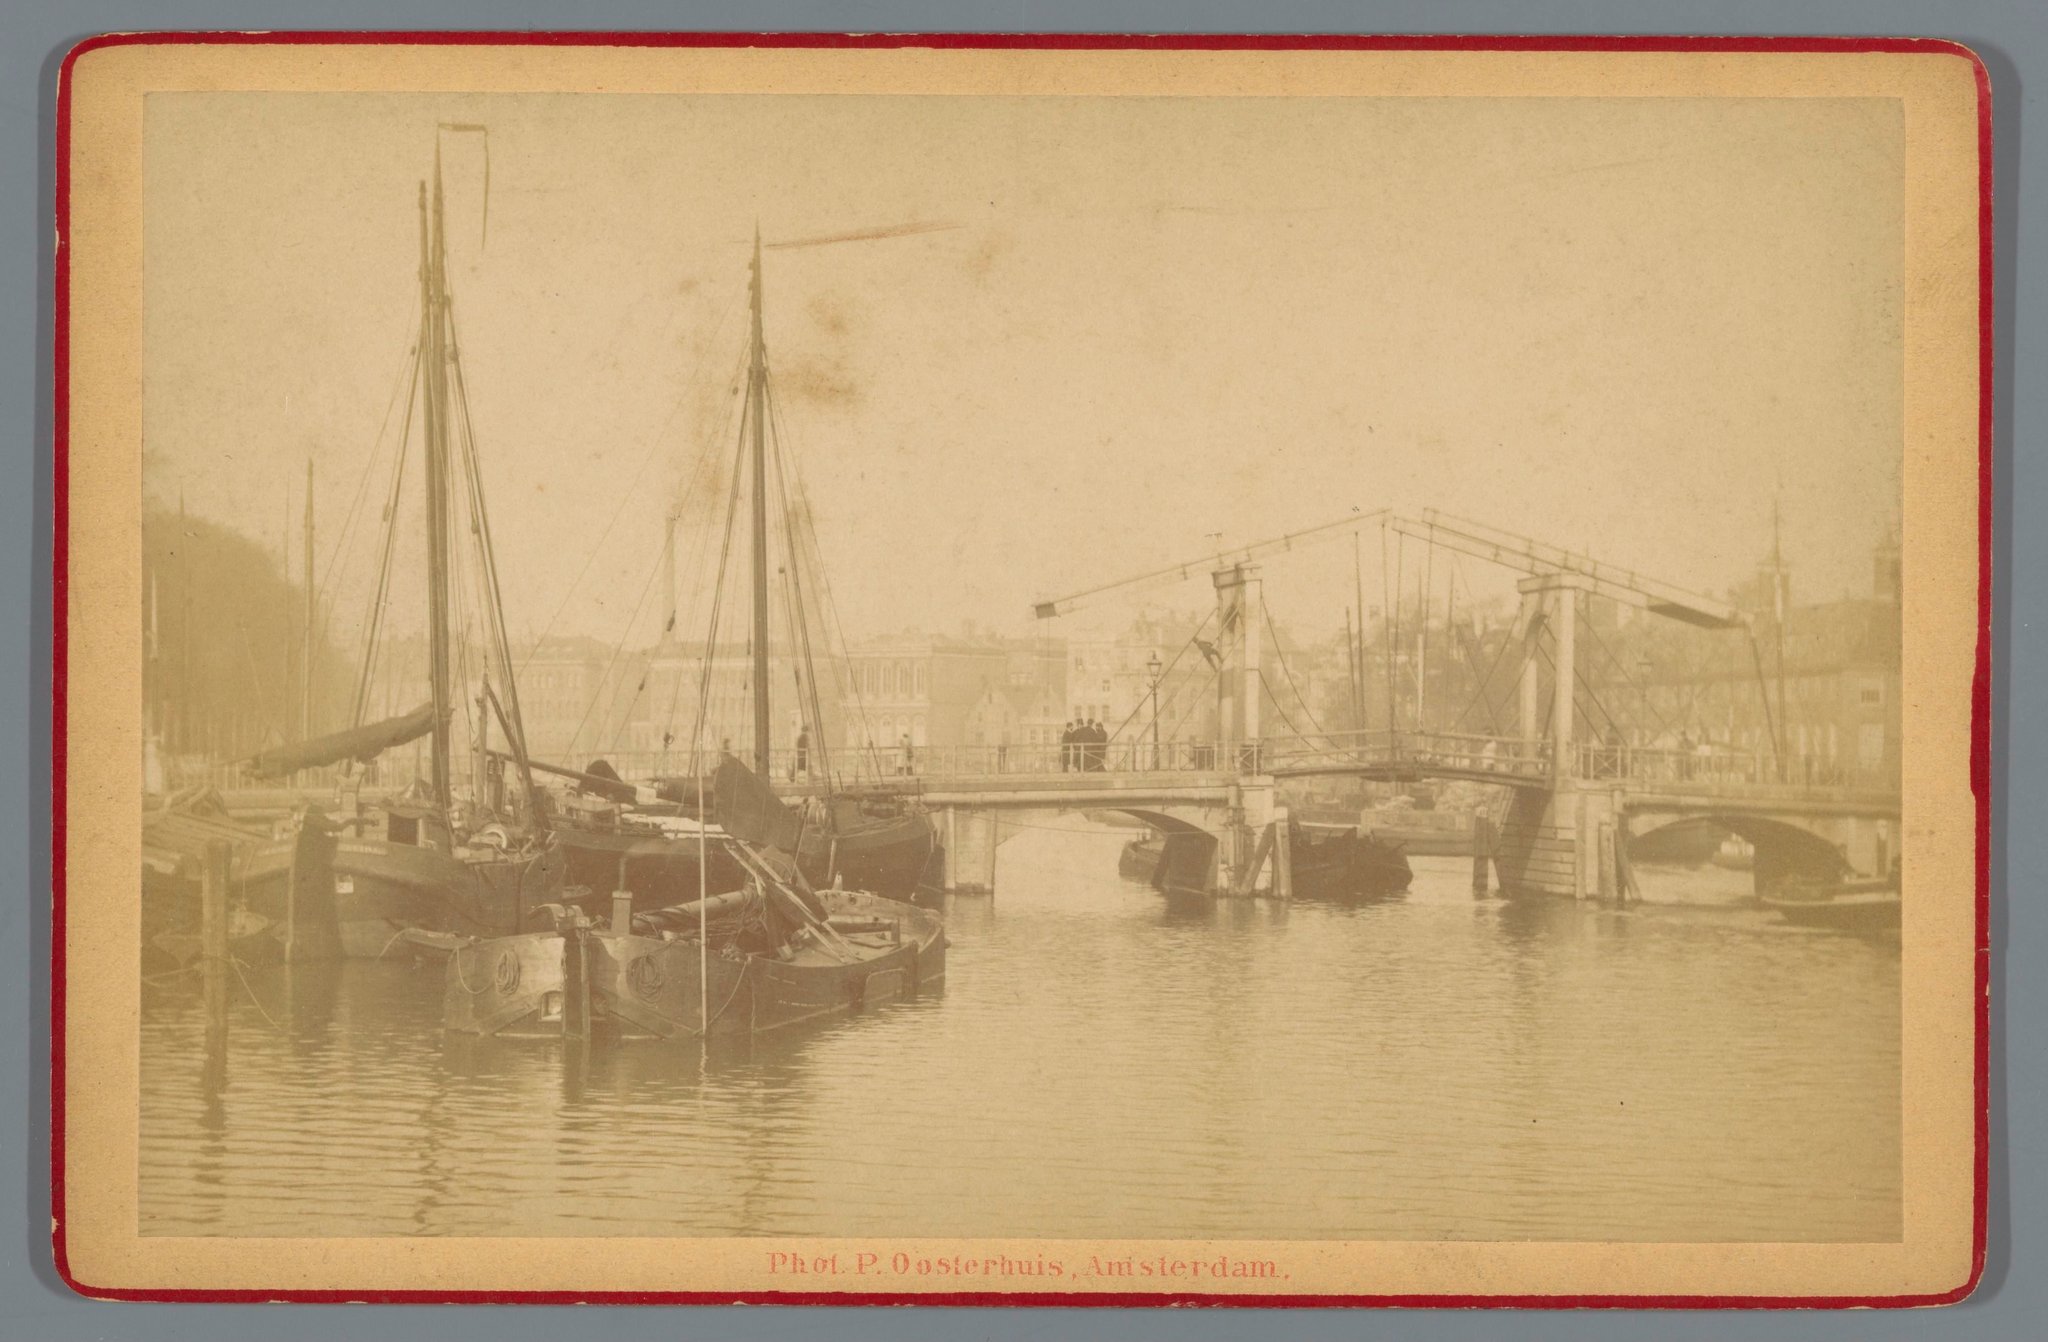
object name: cabinet photograph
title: Magere Brug over de Amstel, gezien richting het noorden, Amsterdam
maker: pieter oosterhuis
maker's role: draughtsman, print maker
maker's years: 1816-1885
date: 1867-1885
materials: cardboard, paper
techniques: albumen print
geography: amsterdam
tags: bridge in city across river, canal, etc.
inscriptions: inscription: ‘5,-’, inscription: ‘Phot. P. Oosterhuis, Amsterdam.’